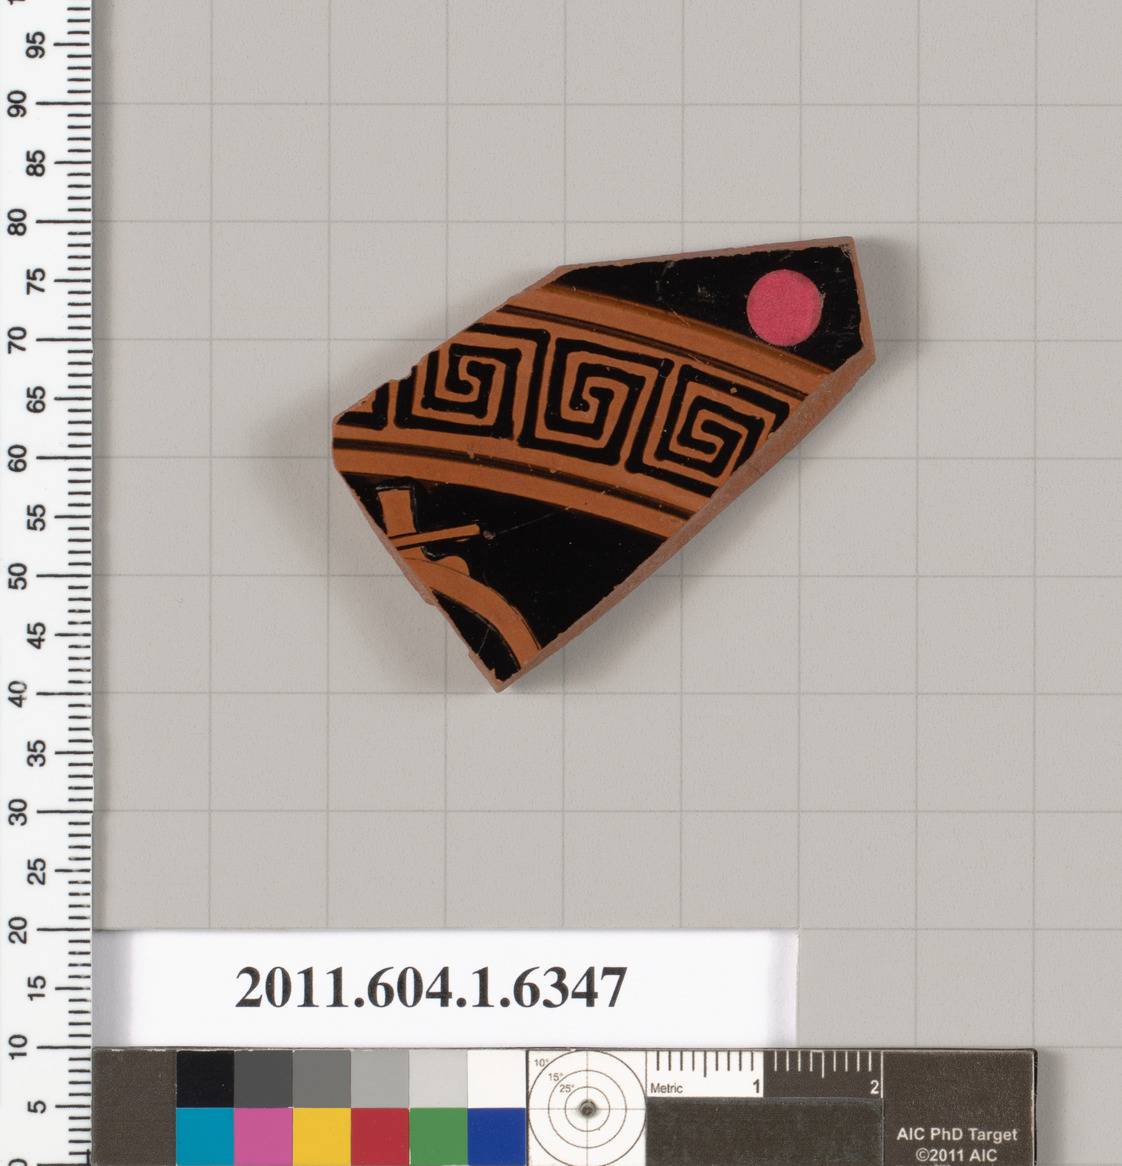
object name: kylix fragment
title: Terracotta fragment of a kylix (drinking cup)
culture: greek, attic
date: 500-480 BCE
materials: terracotta